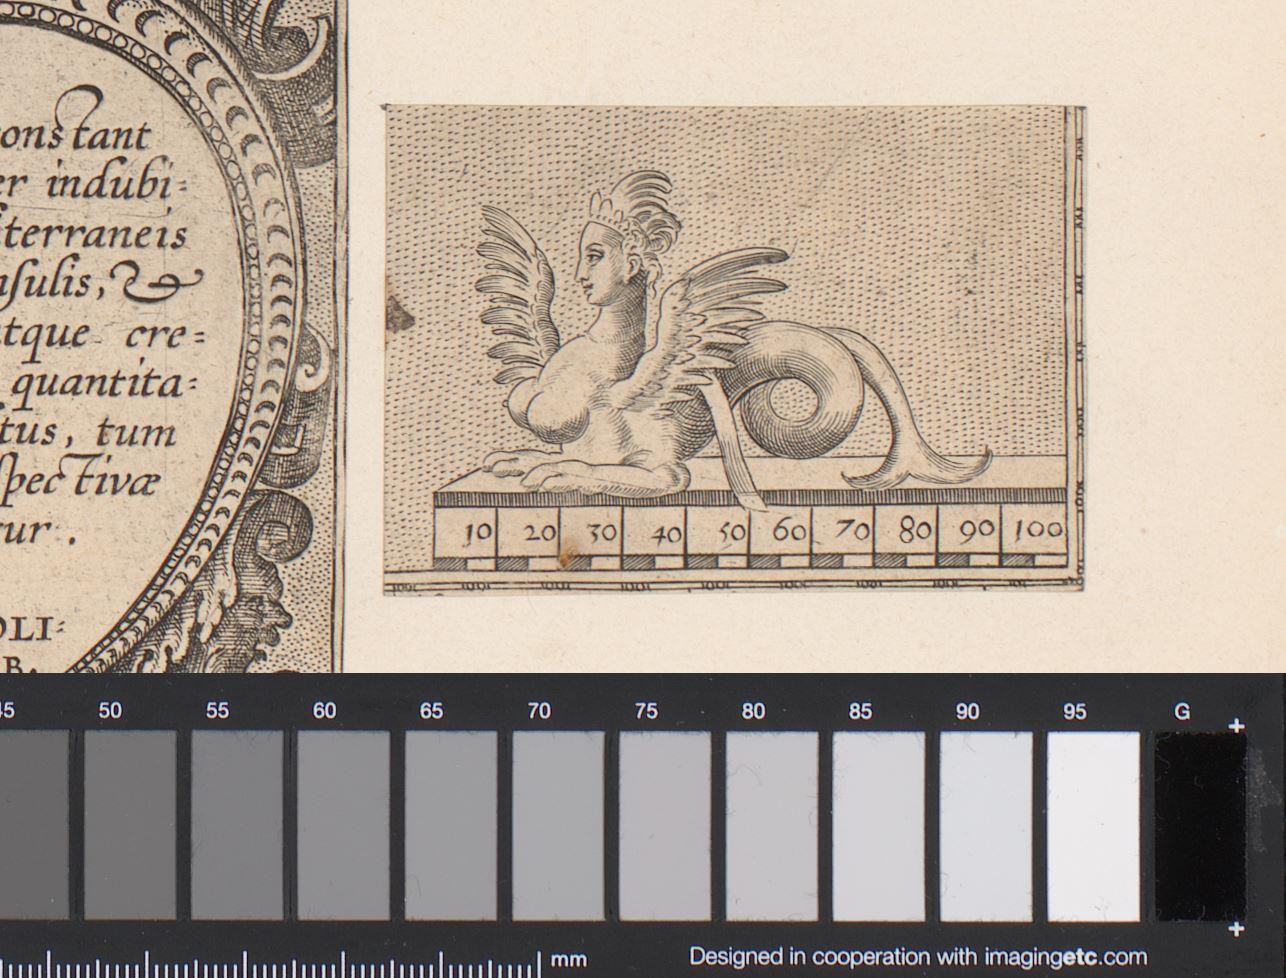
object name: print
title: Schaalstok met sfinx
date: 1584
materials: paper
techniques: engraving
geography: antwerp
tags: sphinx (lion/woman); 'sfinge' (ripa), ornament ~ cartouche, animals with human head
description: De sfinx is gekopieerd naar een prent van een anonieme graveur naar het ontwerp van Hans Vredeman de Vries, onderdeel van een serie van rolwerkcartouches met grotesken uit circa 1555-1560.